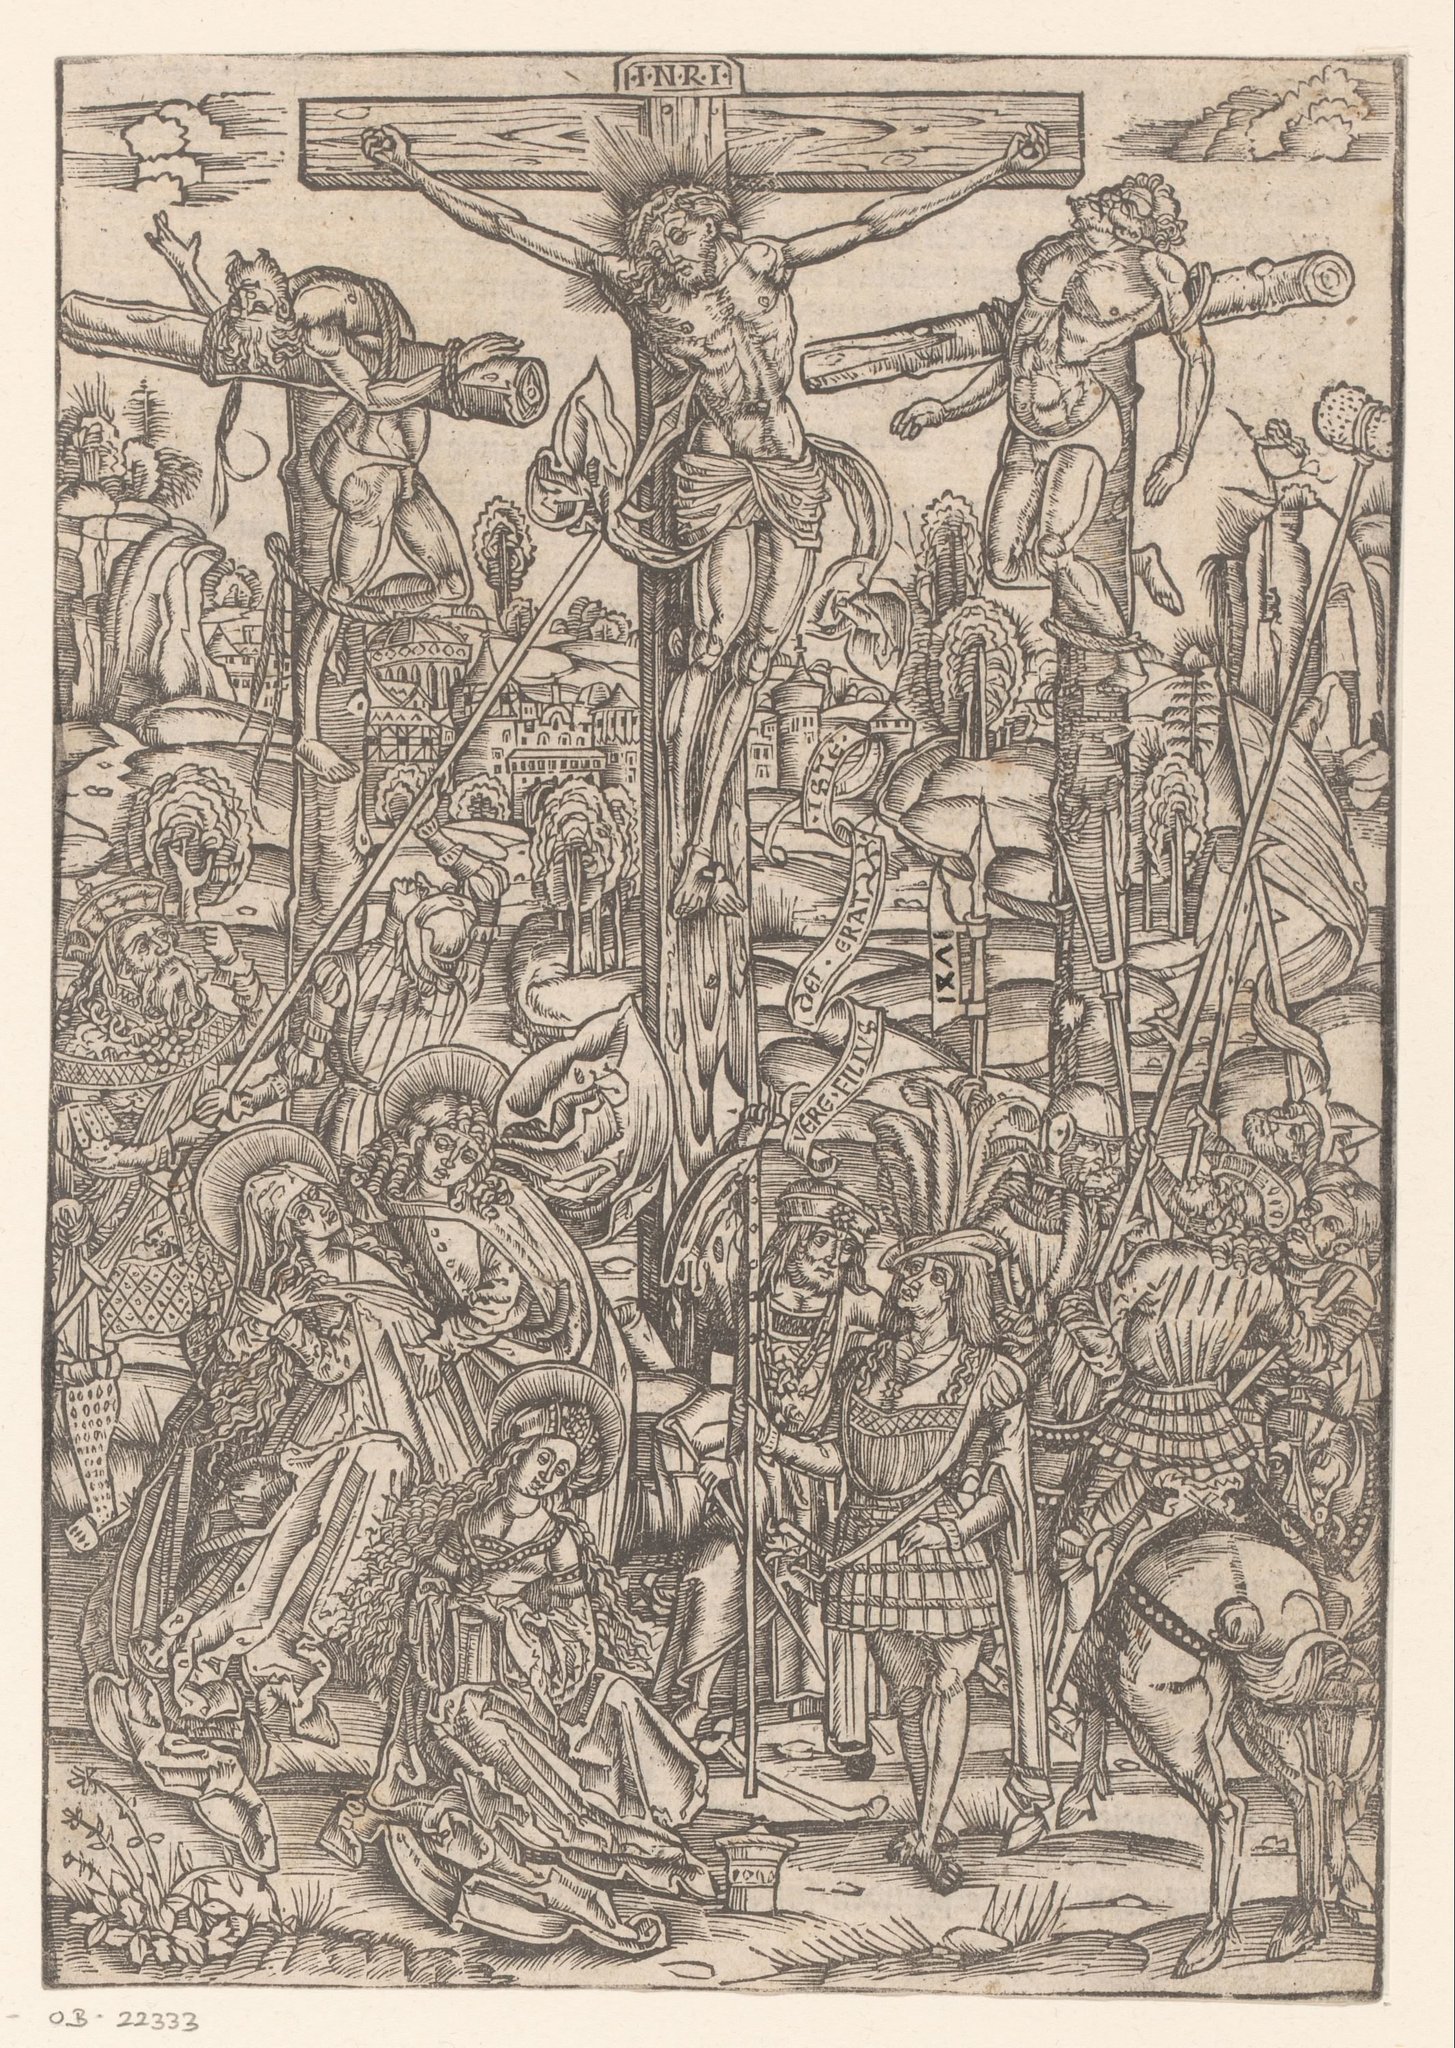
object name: print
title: Kruisiging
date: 1502-1510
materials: paper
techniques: woodcut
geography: straatsburg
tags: the crucifixion of christ: christ's death on the cross; golgotha (matthew 27:45-58; mark 15:33-45; luke 23:44-52; john 19:25-38)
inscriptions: collector's mark: Lugt 240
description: Illustraties waarschijnlijk afkomstig uit: Der heilige leben (...). Straatsburg: Johann Grüninger, 1502 of 1510.